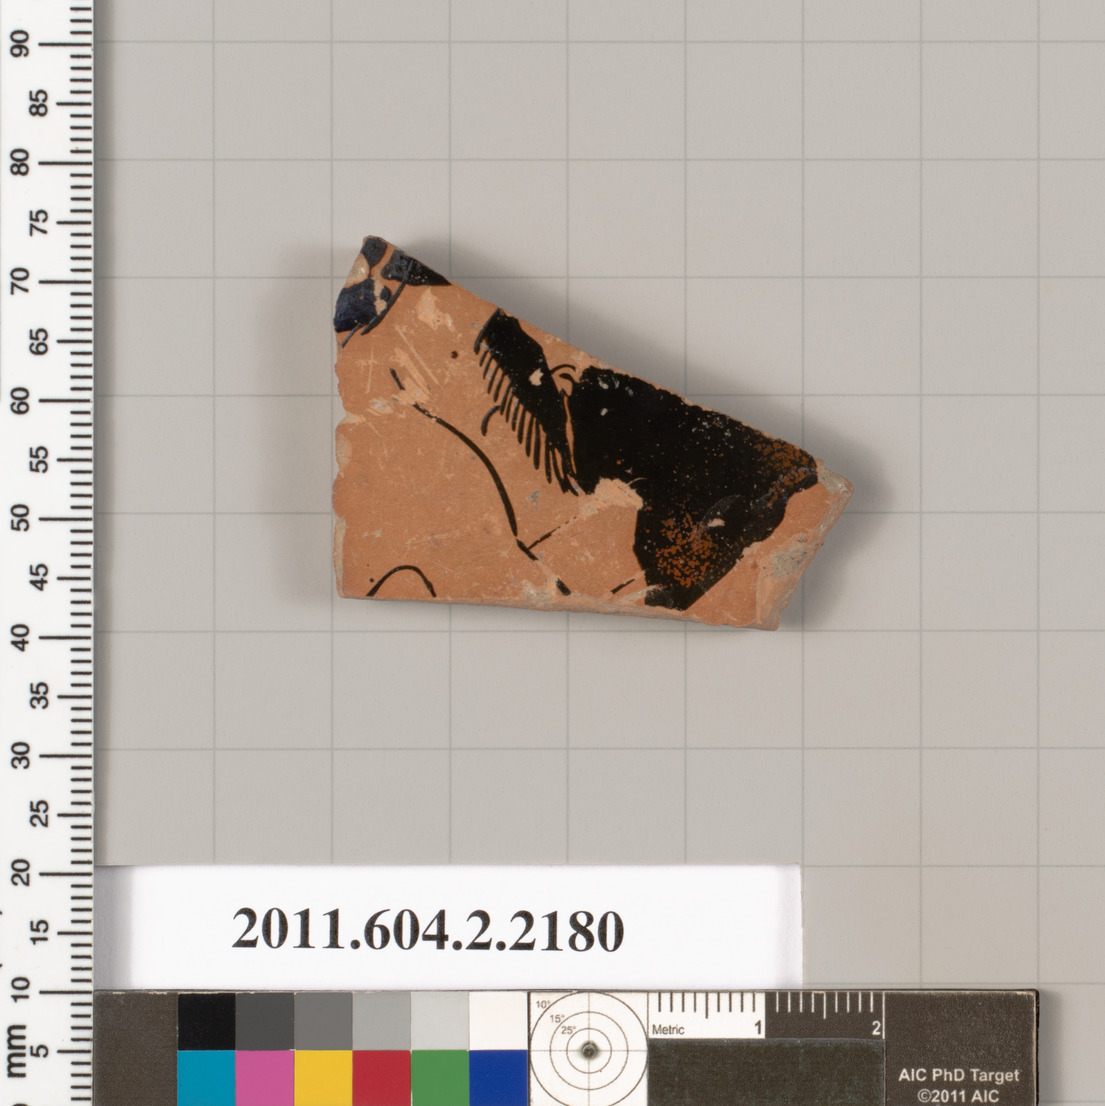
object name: pot fragment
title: Terracotta fragment of a pot; unglazed on the inside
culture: greek, attic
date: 490-470 BCE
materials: terracotta